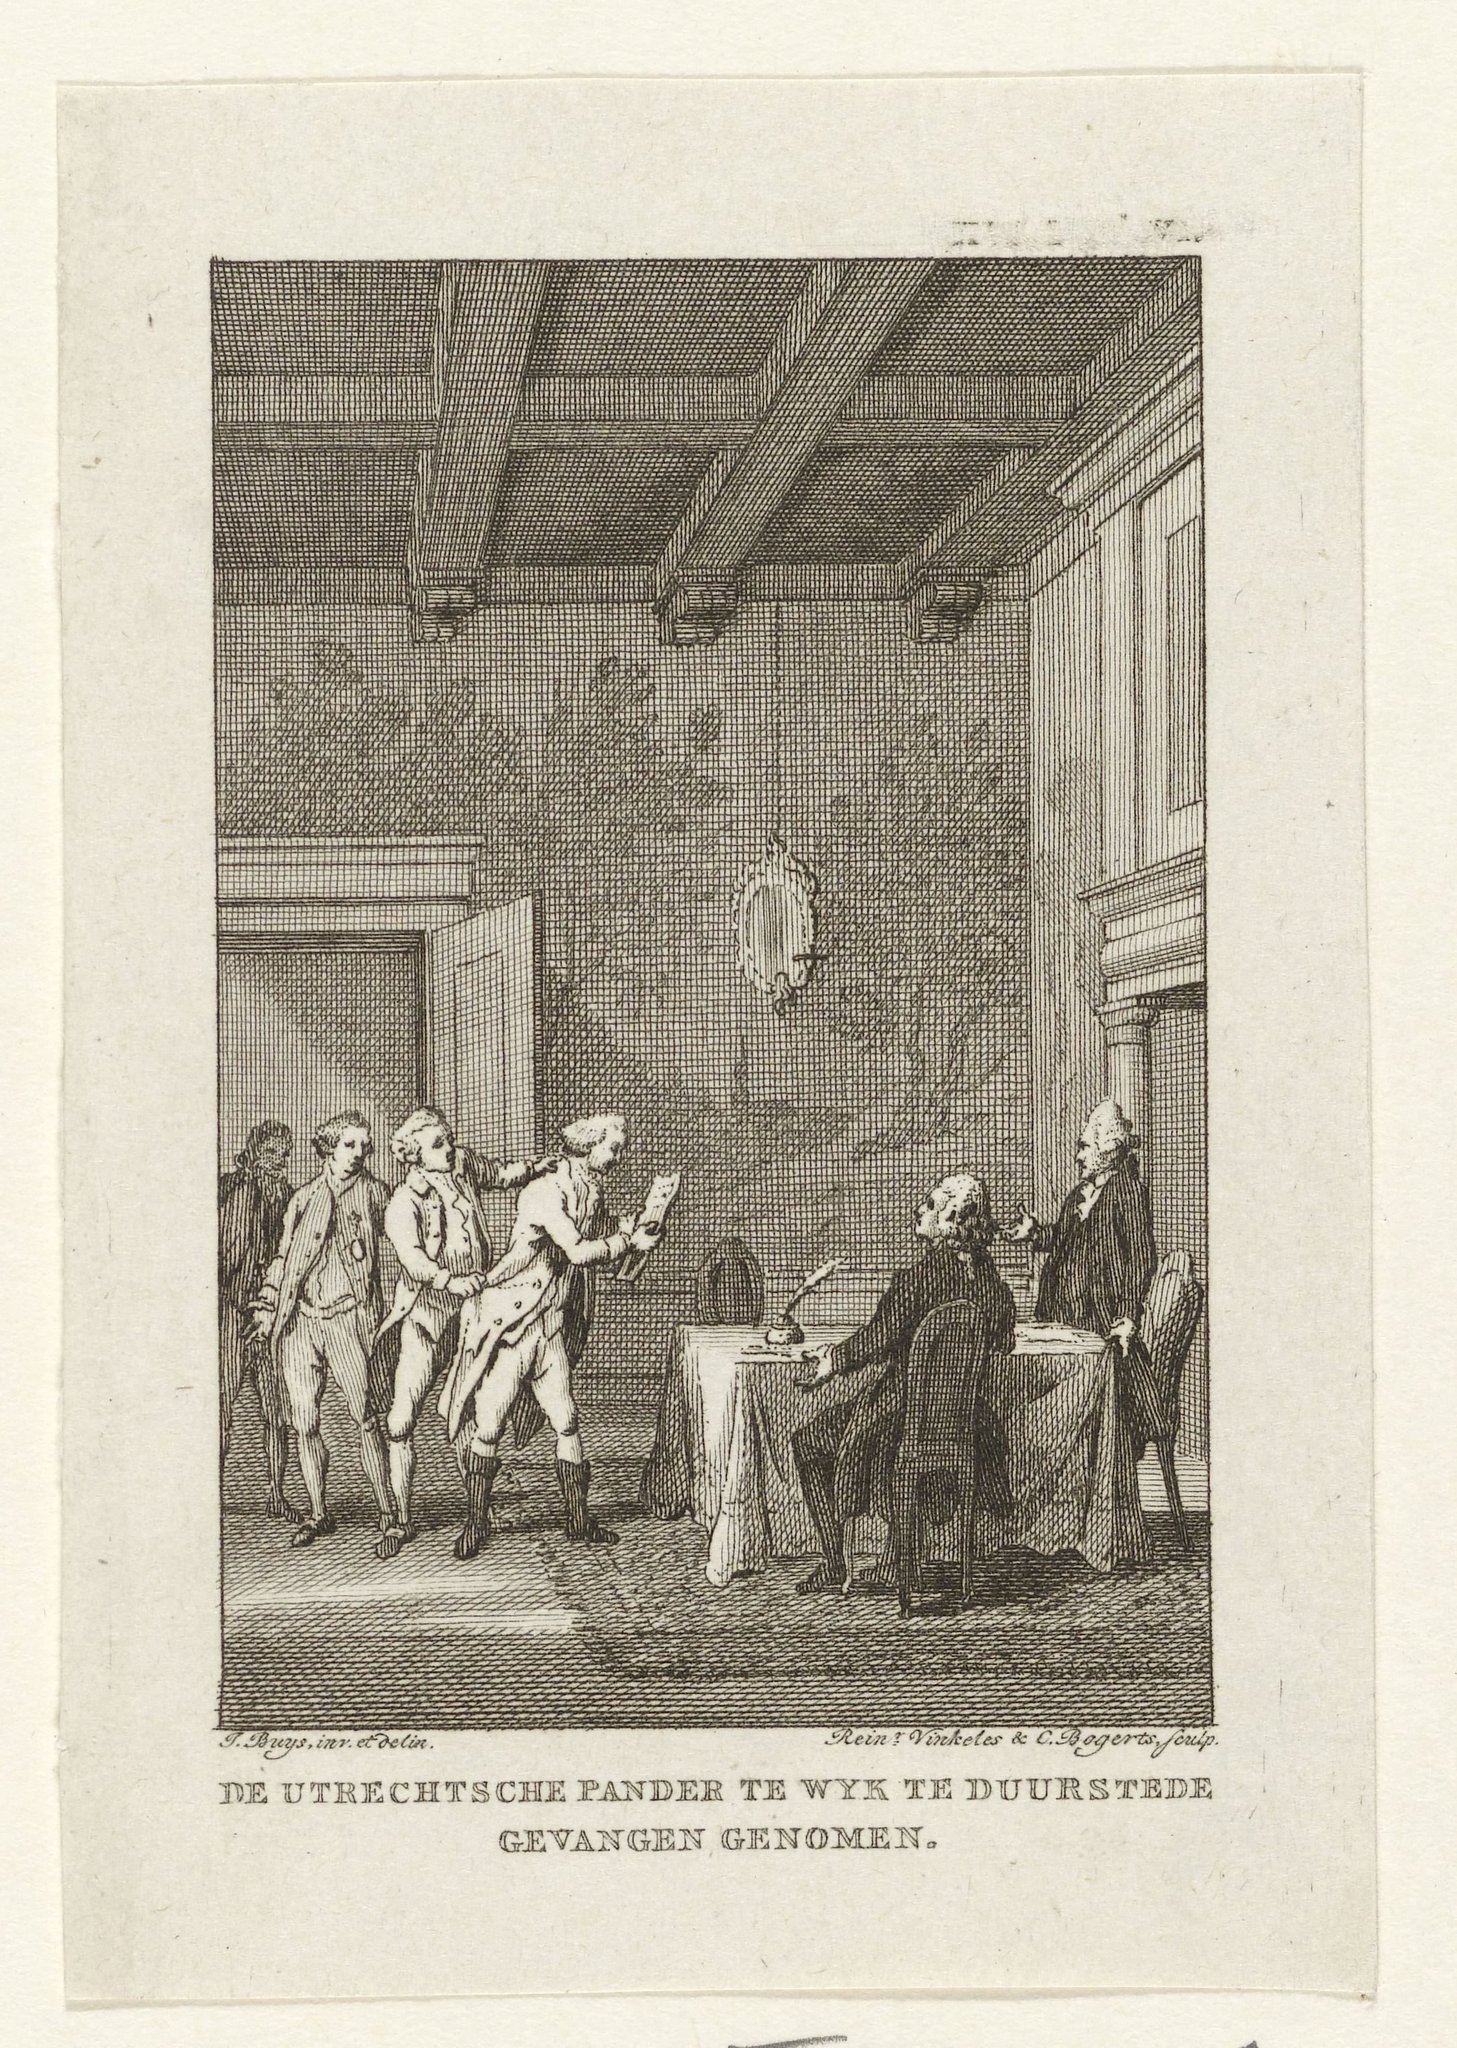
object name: print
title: Gevangenneming van de Utrechtse pander, 1786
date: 1786-1795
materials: paper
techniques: engraving, etching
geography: northern netherlands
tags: arrest (of criminal), wijk bij duurstede, utrecht, patriots (1780-1795)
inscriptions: collector's mark: Lugt 2228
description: Gebruikt als illustratie in: J. Fokke, Geschiedenissen der Vereenigde Nederlanden voor de vaderlandsche jeugd, Johannes Allart, Amsterdam 1783-1795, 25 delen, dl. 16, pl. 6.